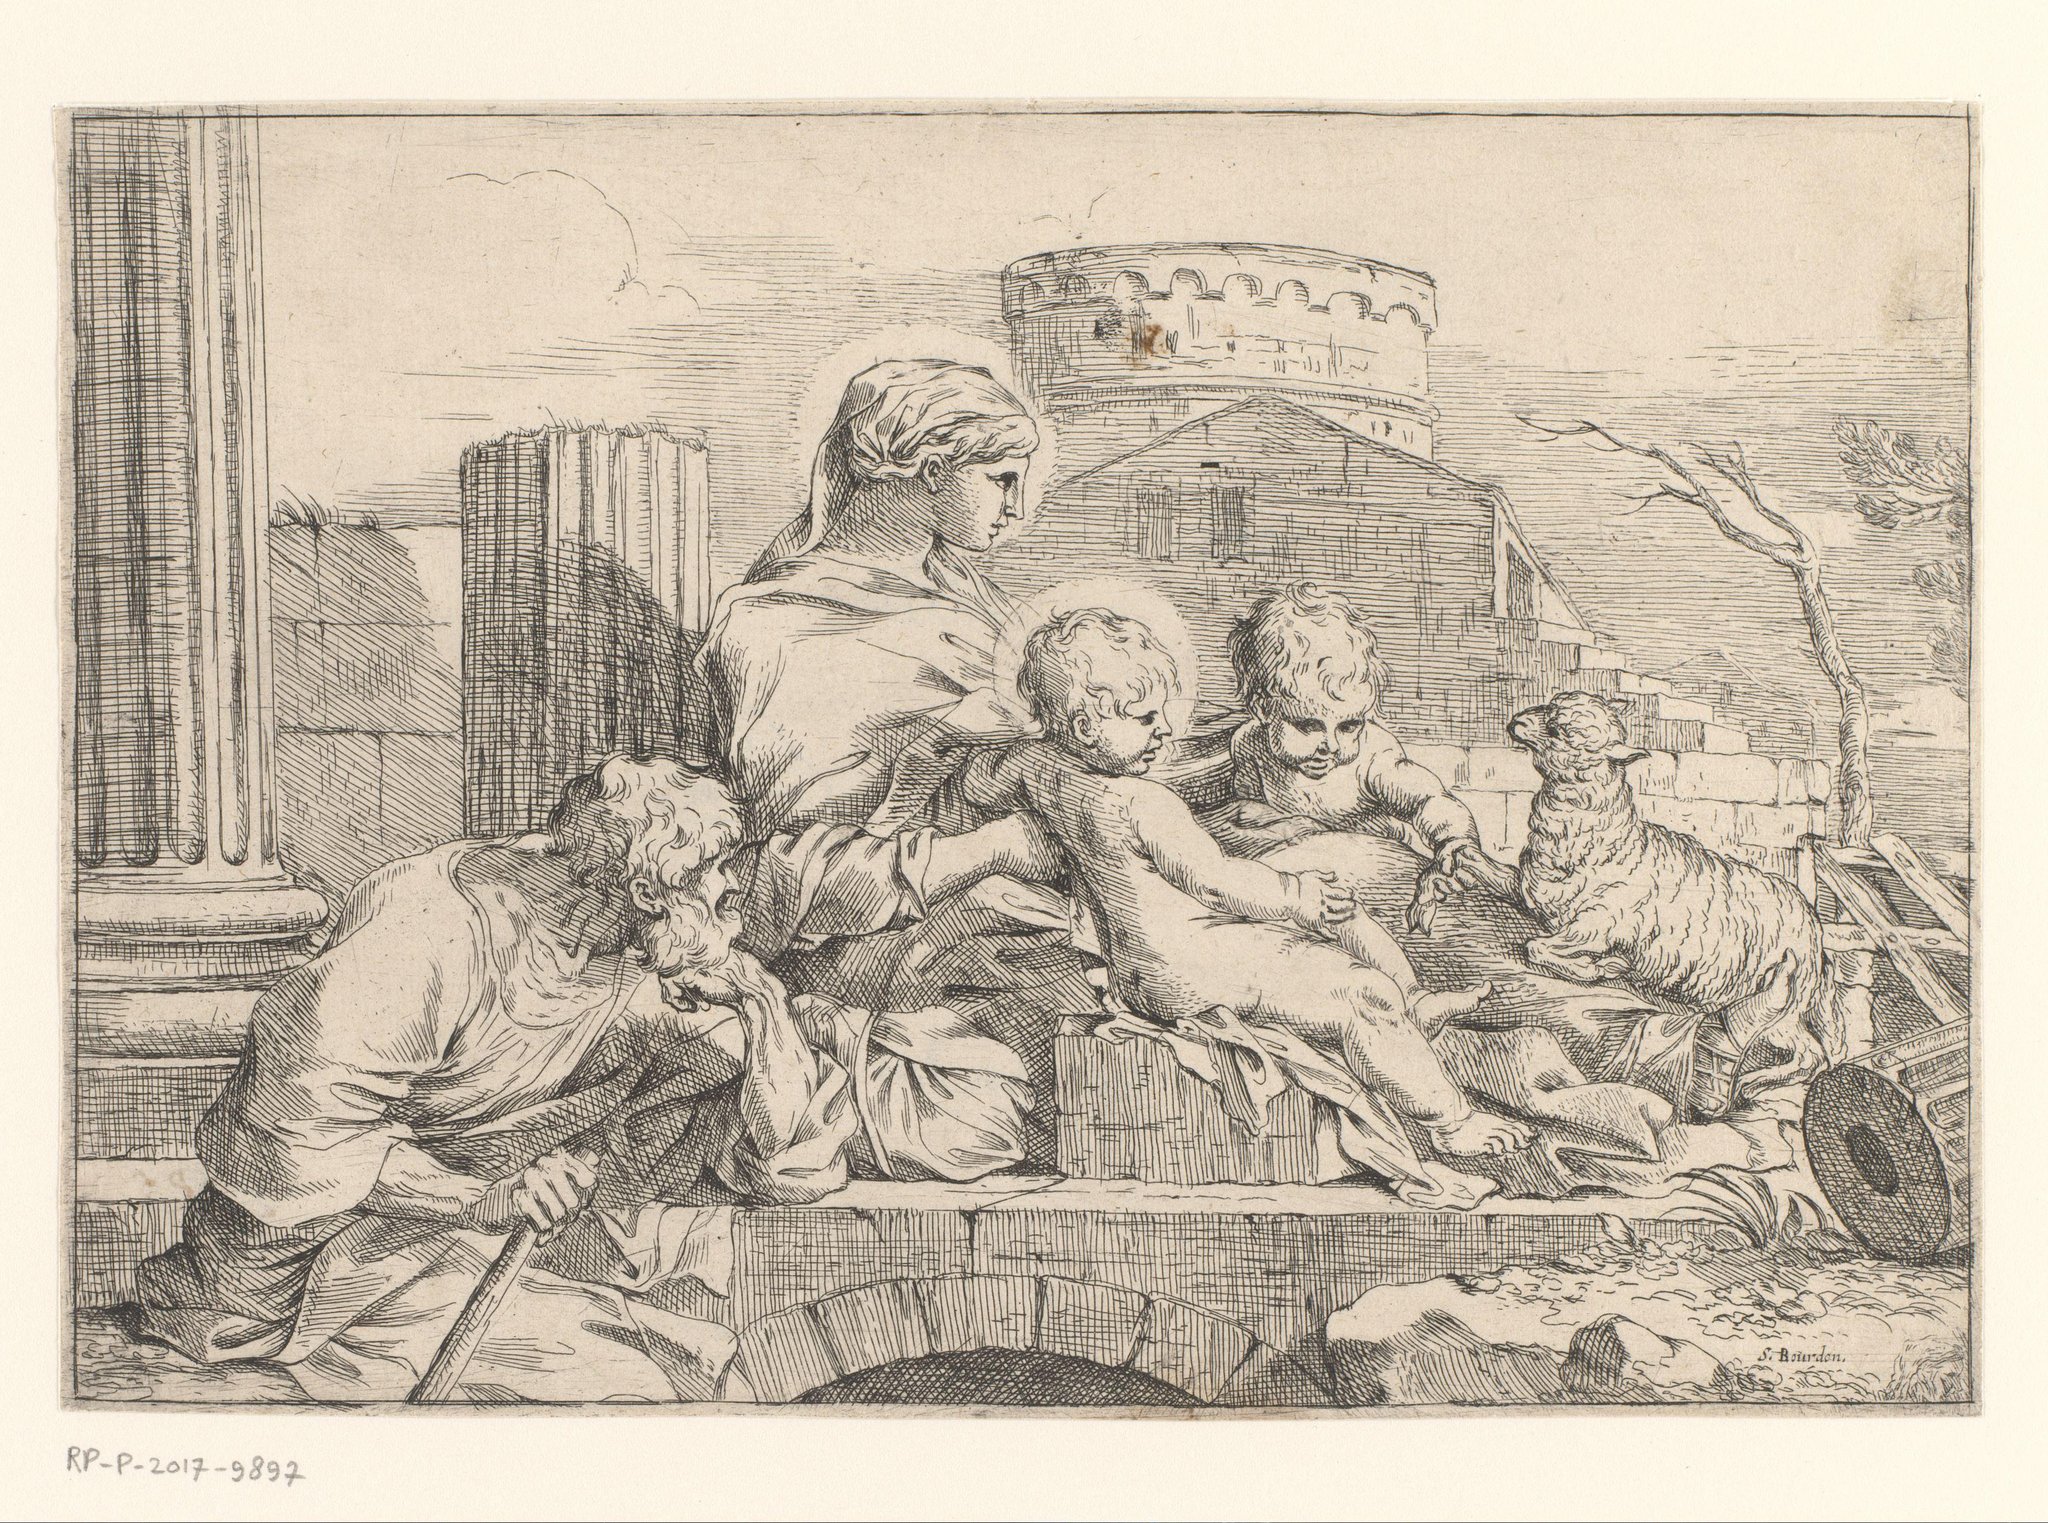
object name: print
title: Heilige Familie met Johannes en lam tussen ruïnes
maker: sébastien bourdon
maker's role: draughtsman, painter, print maker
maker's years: 1616-1671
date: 1626-1671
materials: paper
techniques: etching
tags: holy family with john the baptist (as child)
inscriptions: collector's mark: Lugt 2228, inscription: ‘z.R.s’